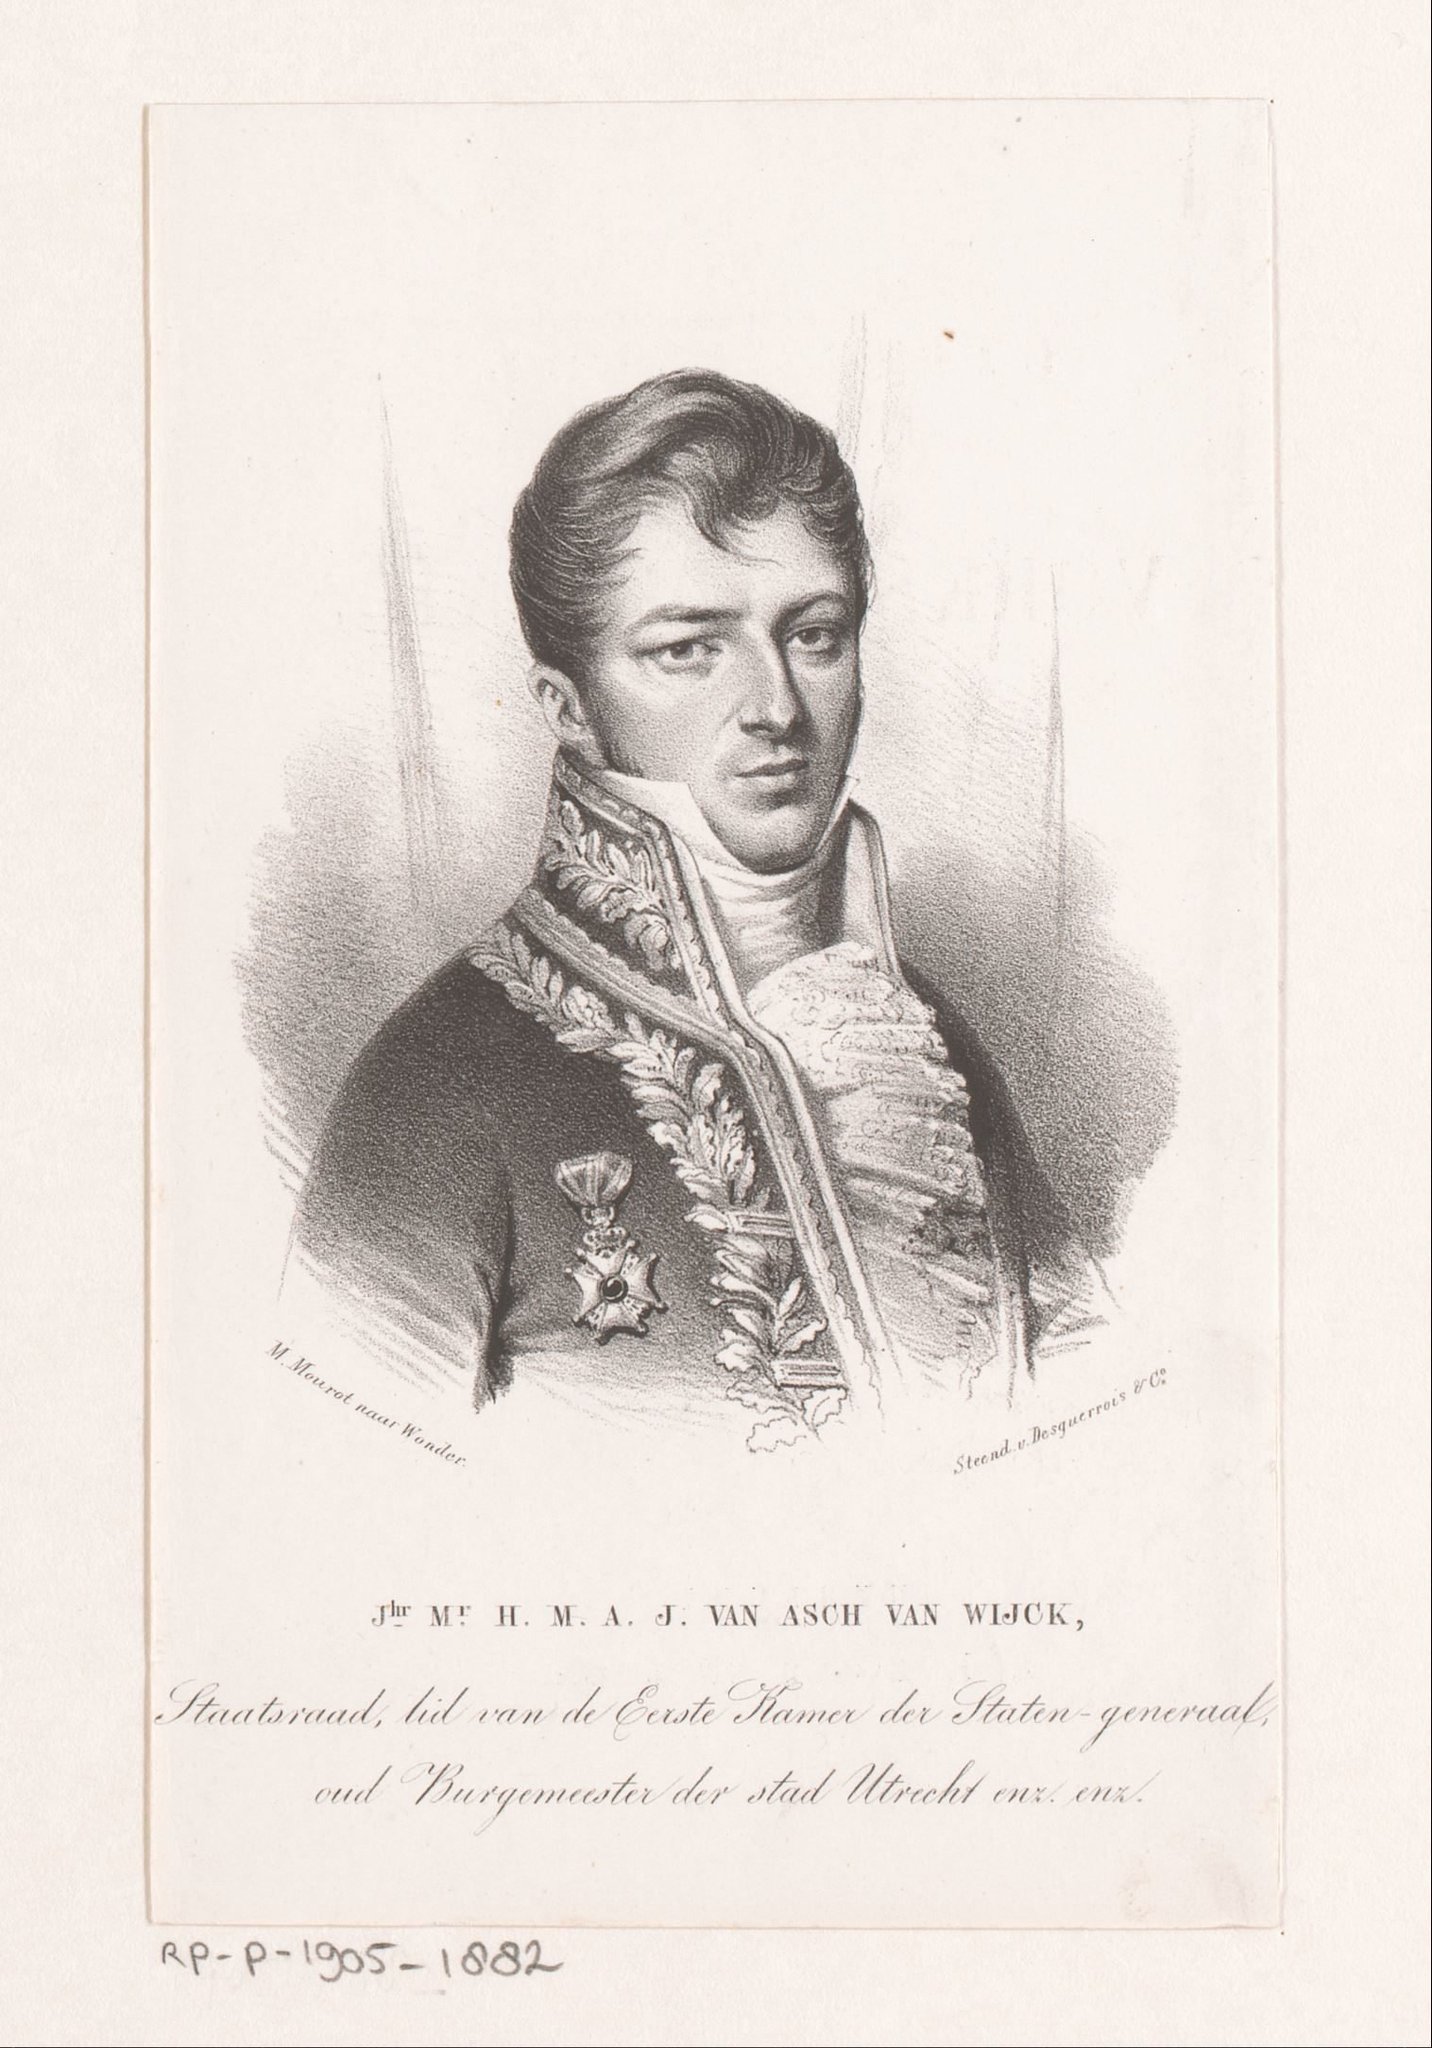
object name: print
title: Portret van Hubert Matthijs Adriaan Jan van Asch van Wijk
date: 1844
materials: paper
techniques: lithograph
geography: amsterdam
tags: woudenberg, politician, knighthood order, historical persons (+ (full) bust portrait)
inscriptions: collector's mark: Lugt 2228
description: Uitgegeven in: Utrechtsche volks-almanak voor het jaar 1844. Utrecht, L. E. Bosch en Zoon: 1844.